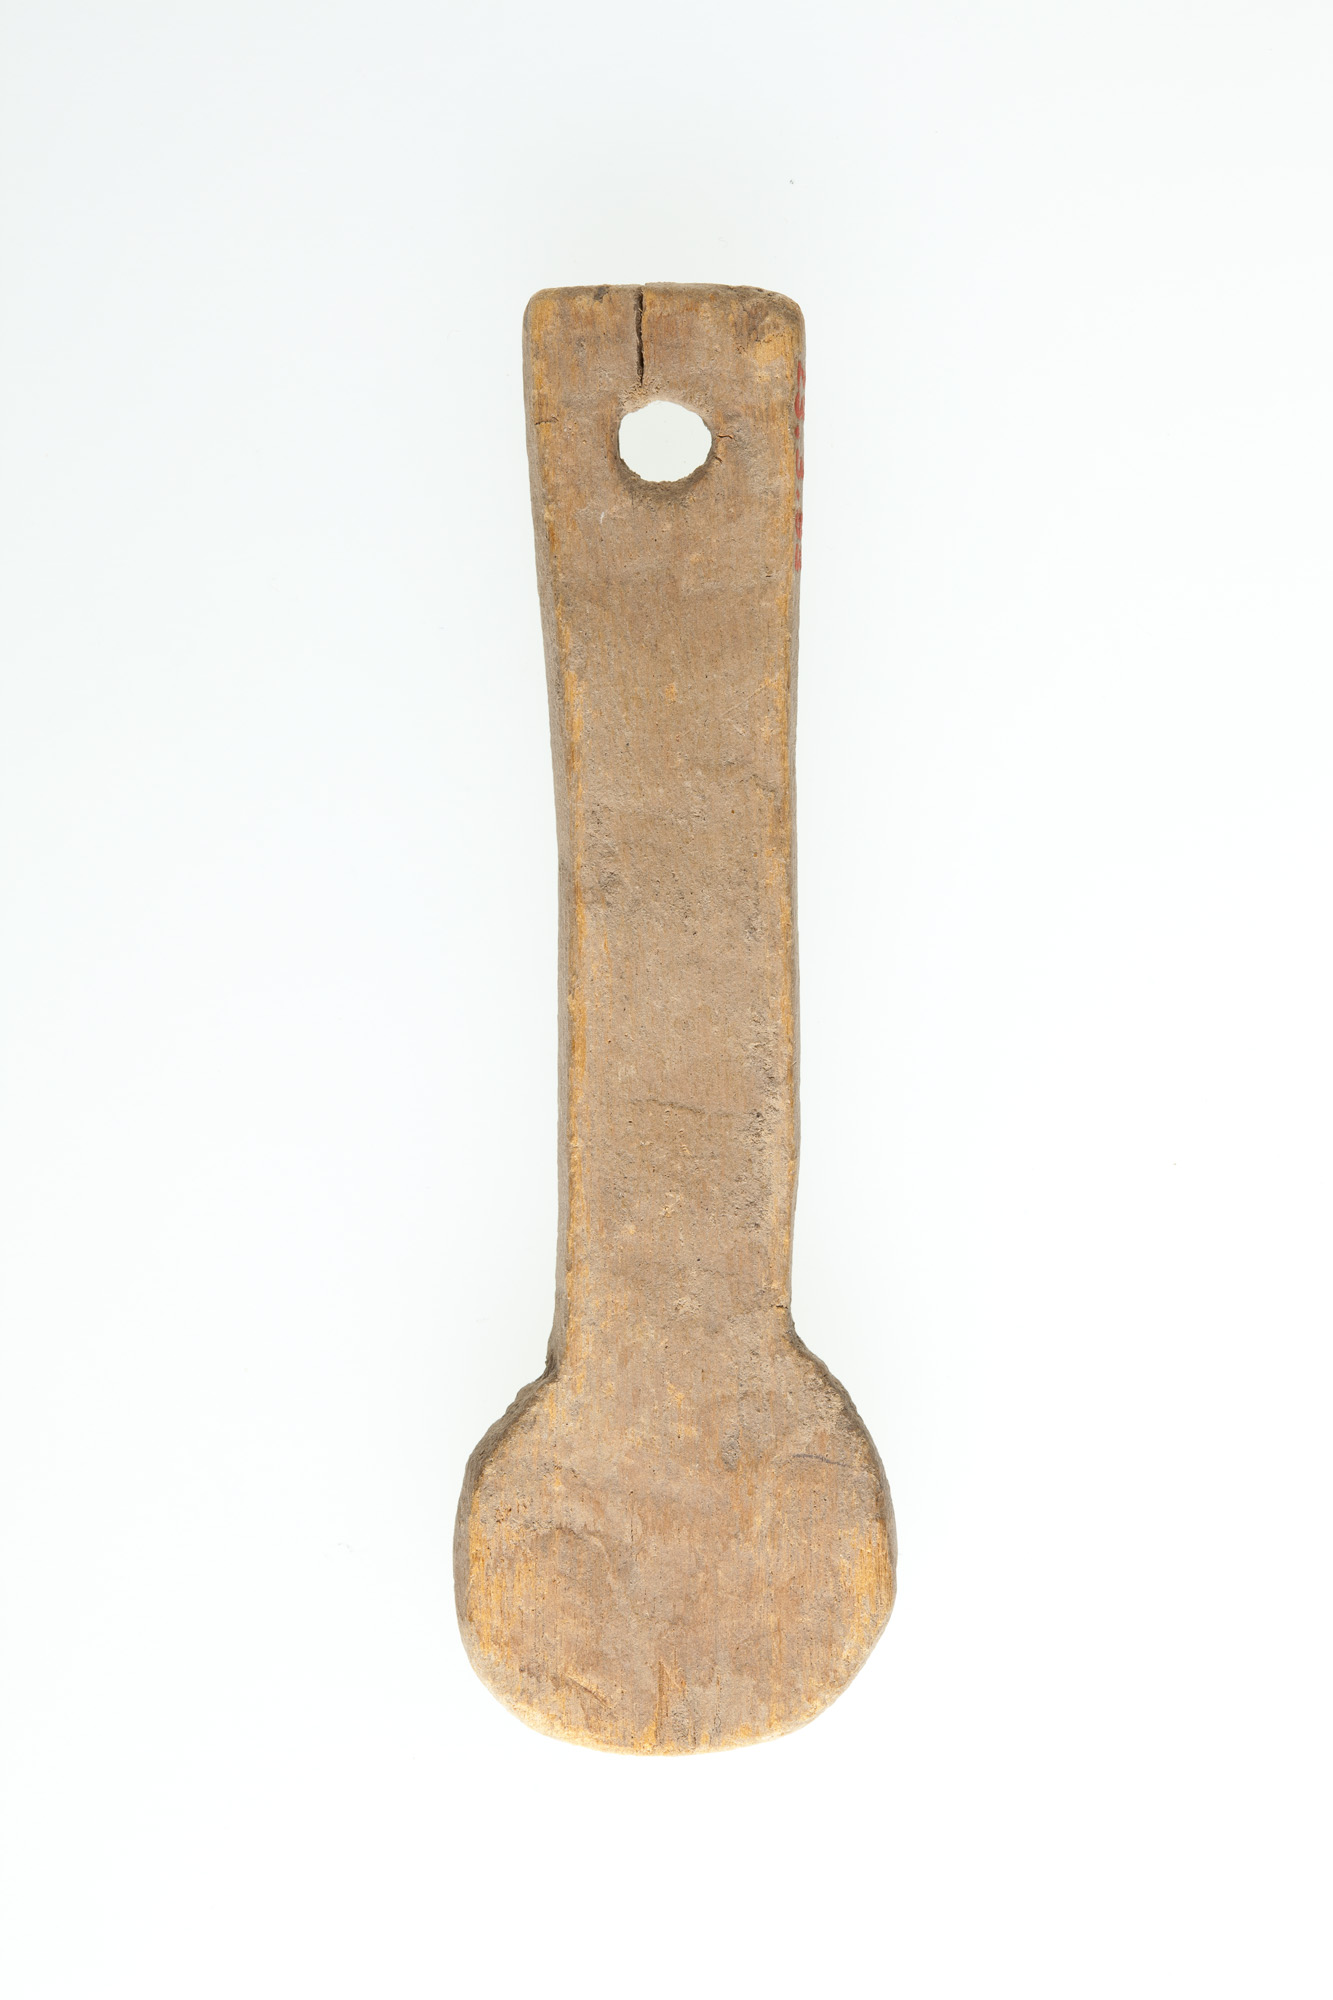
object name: menat fragment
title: Votive fragment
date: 1479-1458 BCE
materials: wood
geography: egypt